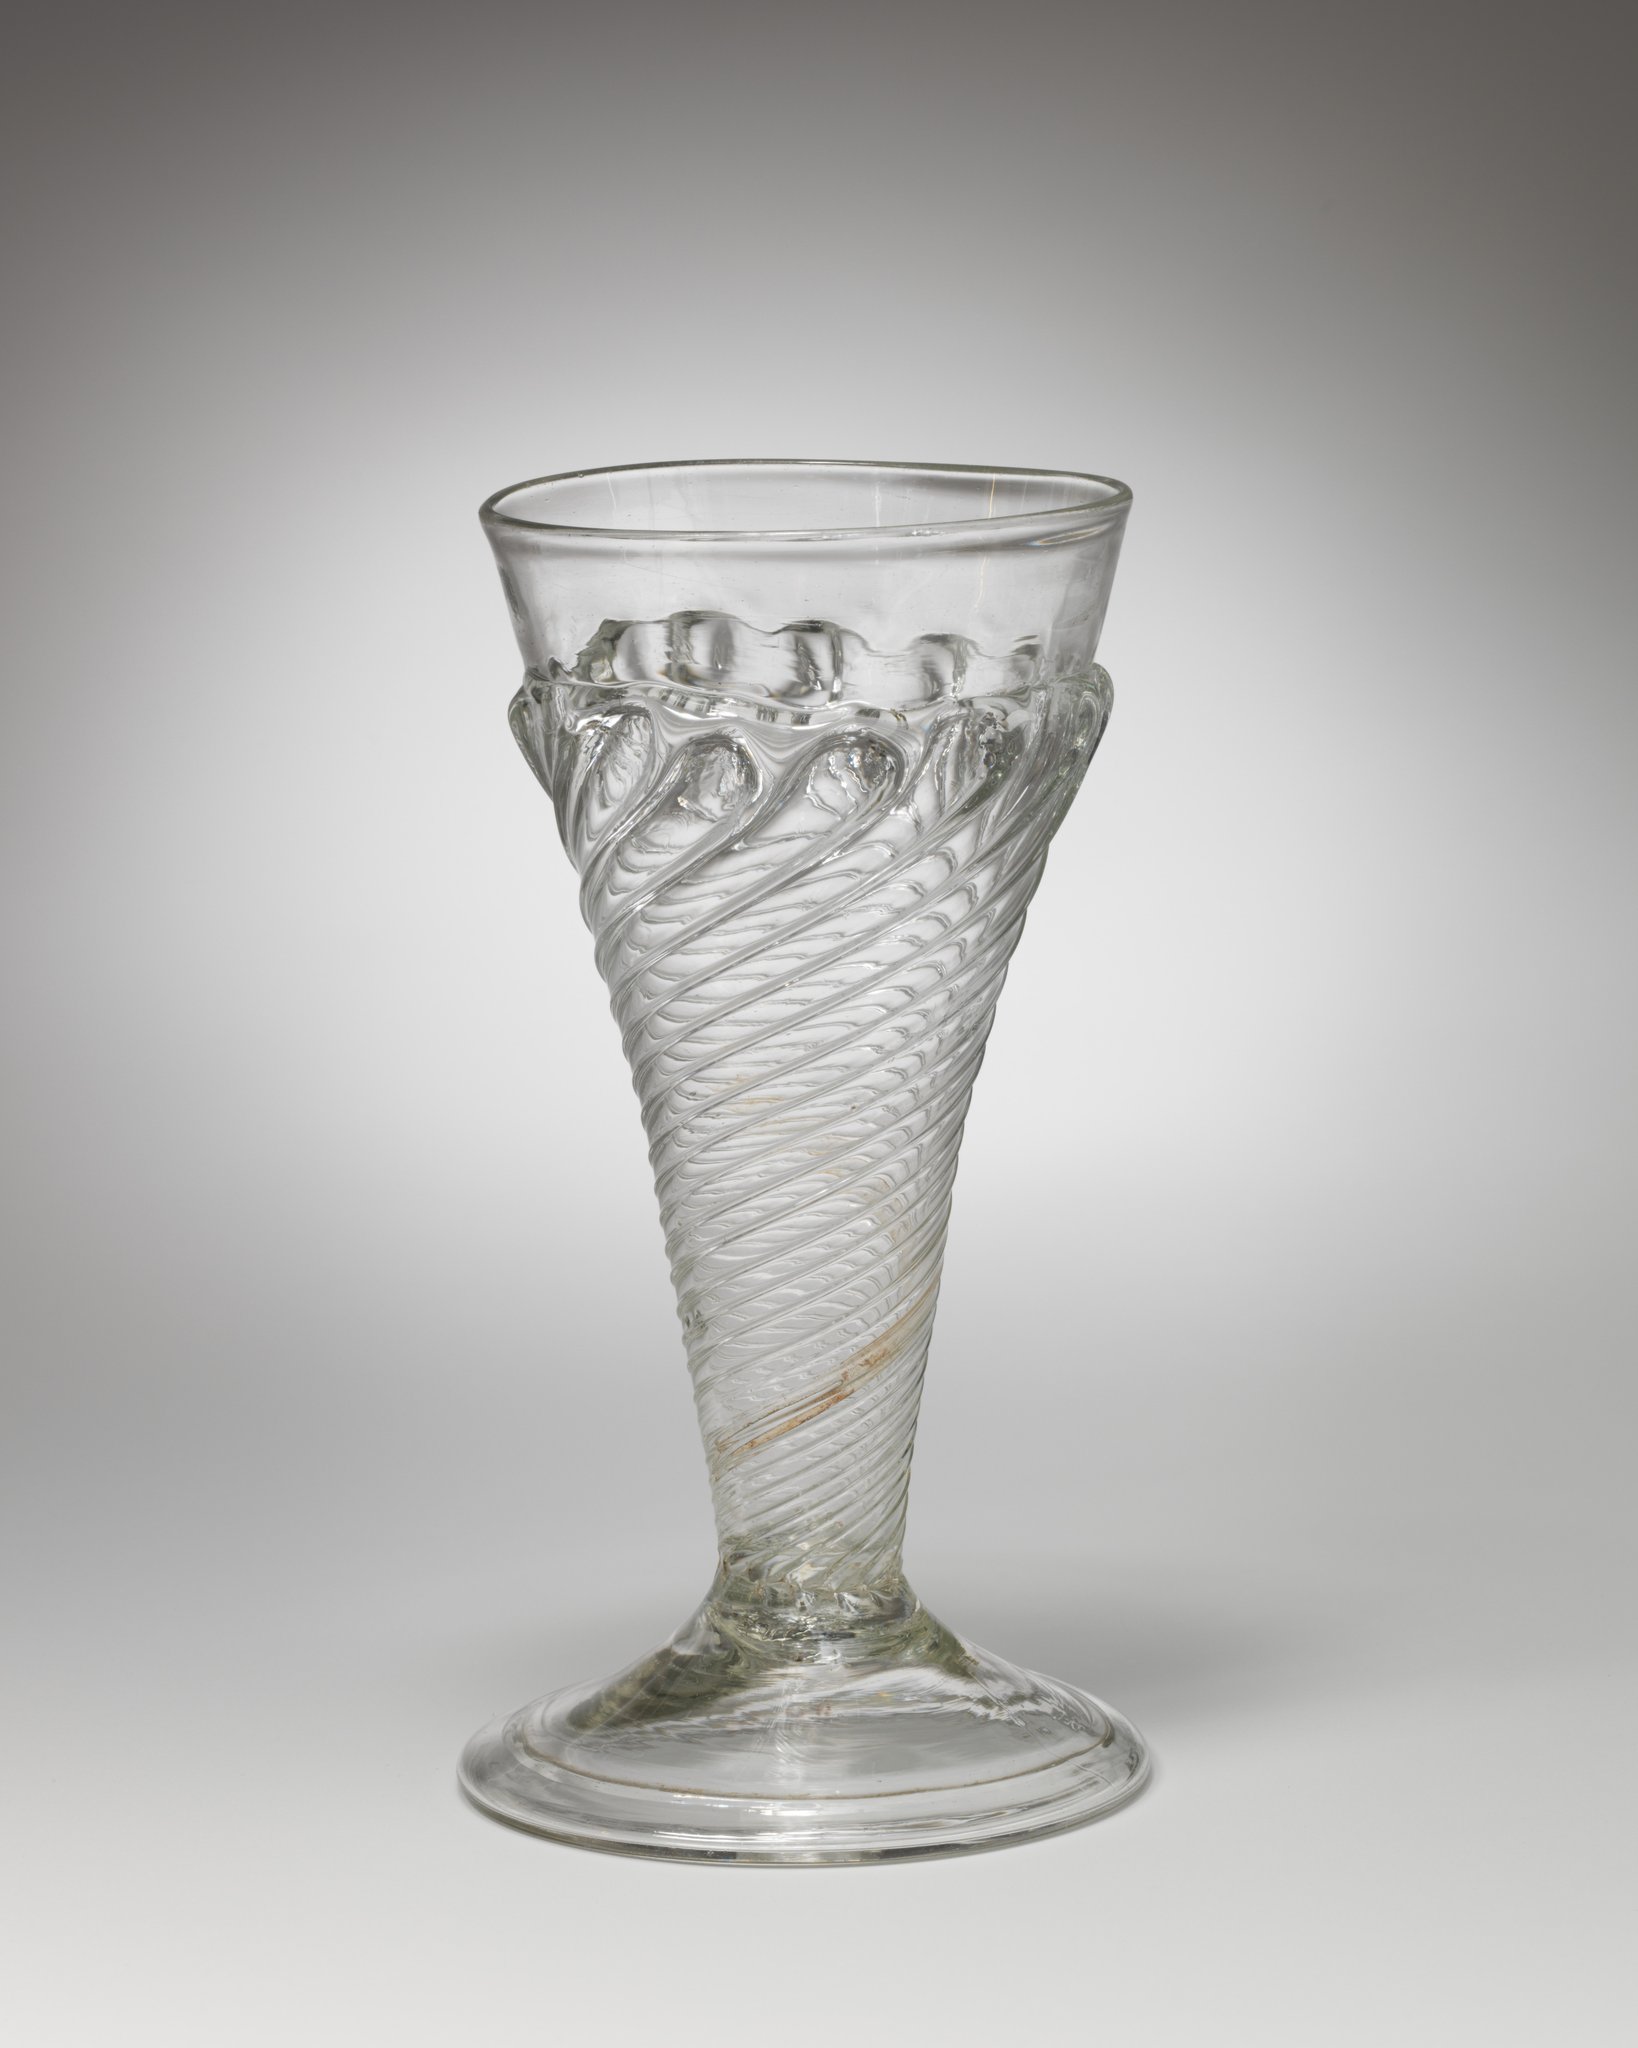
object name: ale glass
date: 1767-1800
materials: glass